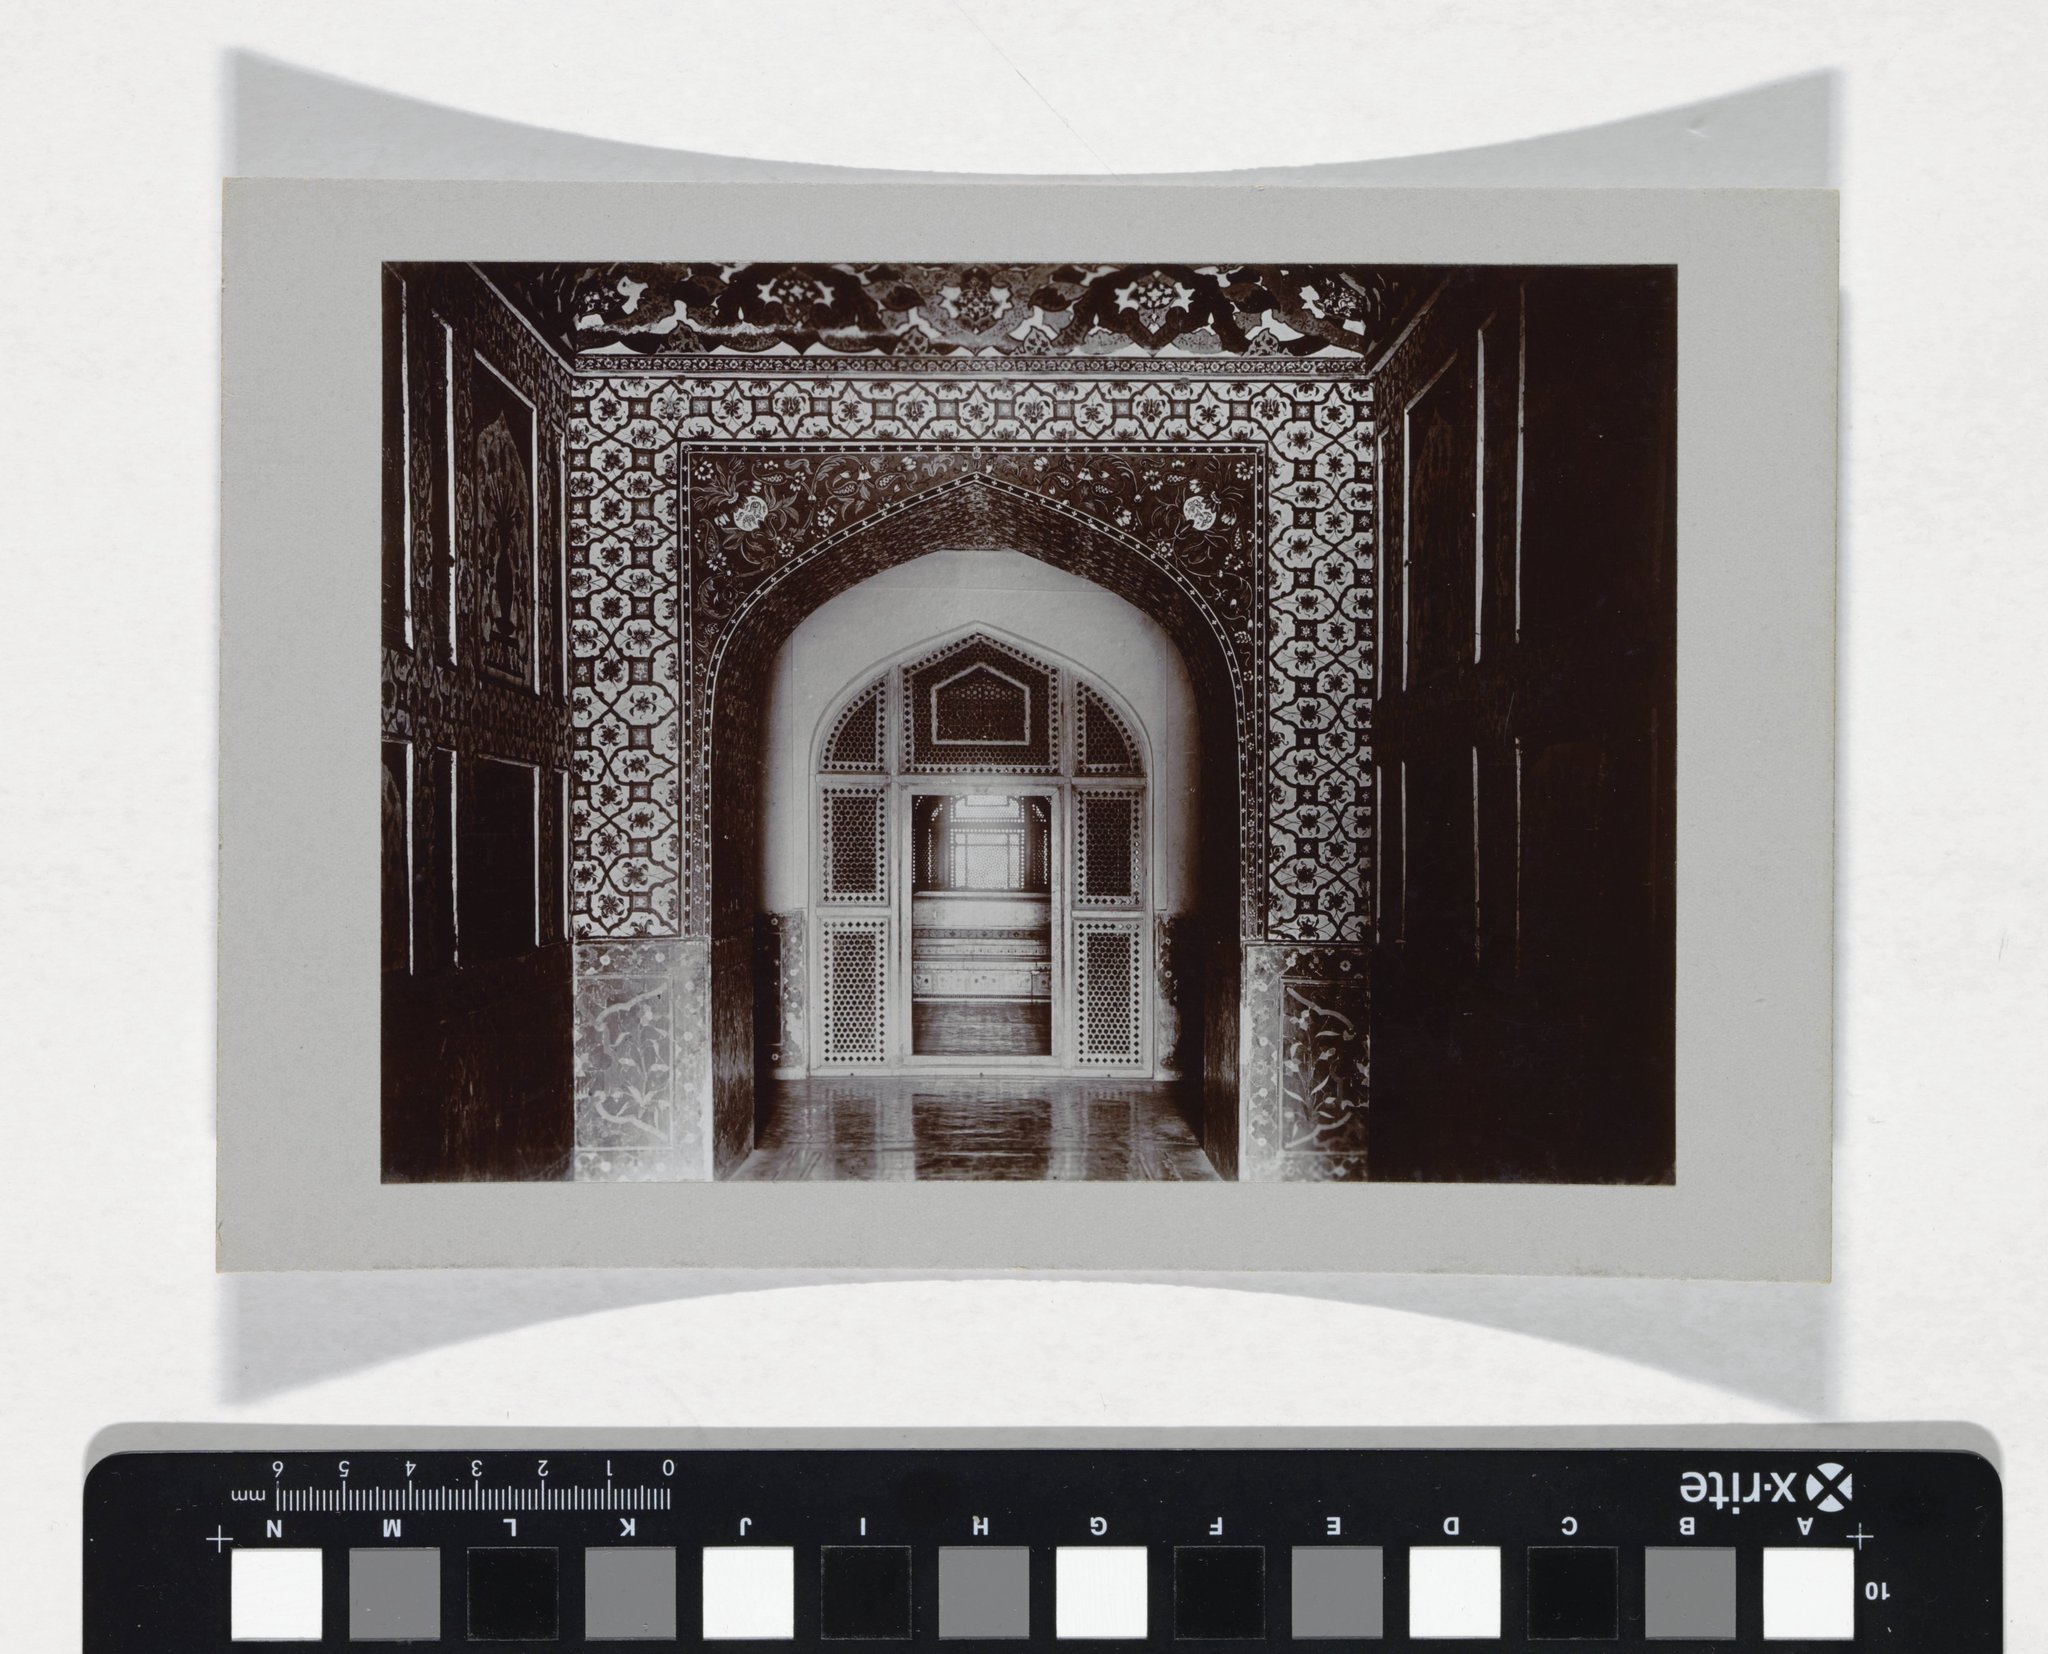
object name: photograph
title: Decorated passageway in a mosque at Lahore, Punjab, Pakistan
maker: Anonymous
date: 1895-1915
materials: cardboard, paper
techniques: gelatin silver print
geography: lahore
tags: lahore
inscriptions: annotation: ‘18b Tempel te Lahore.’